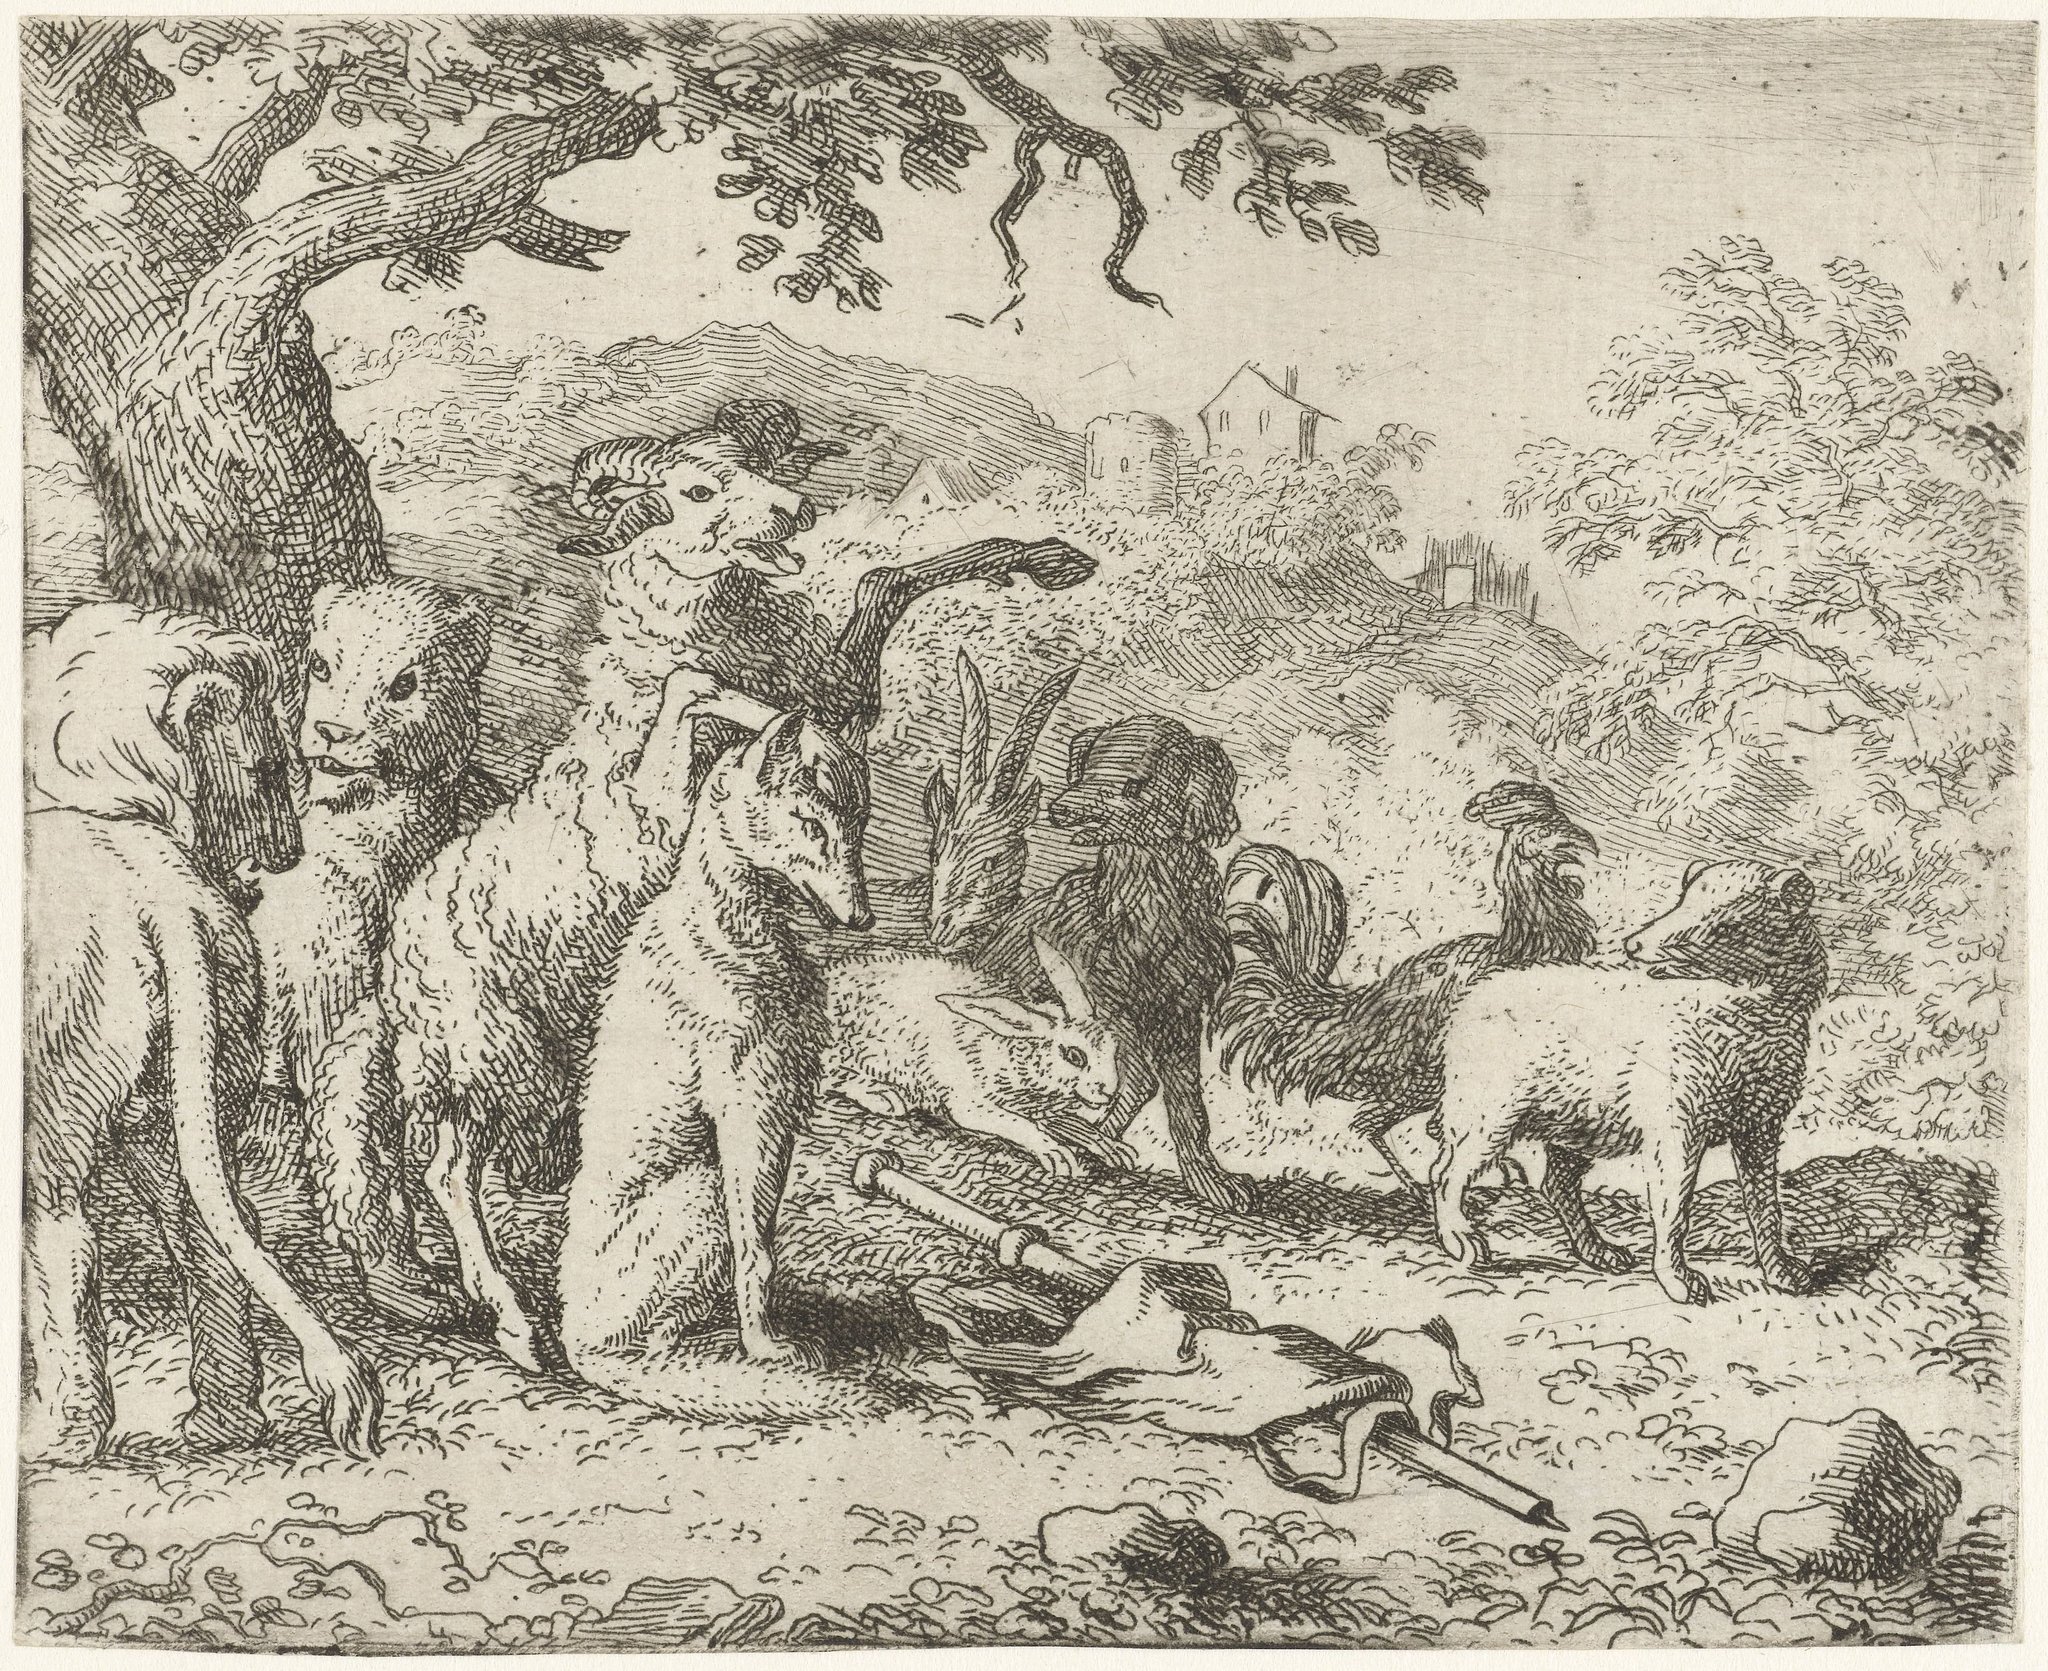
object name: print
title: Reinaert de vos krijgt de zegen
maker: allaert van everdingen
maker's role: draughtsman, painter, print maker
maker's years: 1621-1675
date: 1665-1675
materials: paper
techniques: etching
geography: netherlands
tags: fable of reynard the fox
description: Belijn de ram zegent Reinaert de vos ter voorbereiding van zijn pelgrimstocht naar Rome.